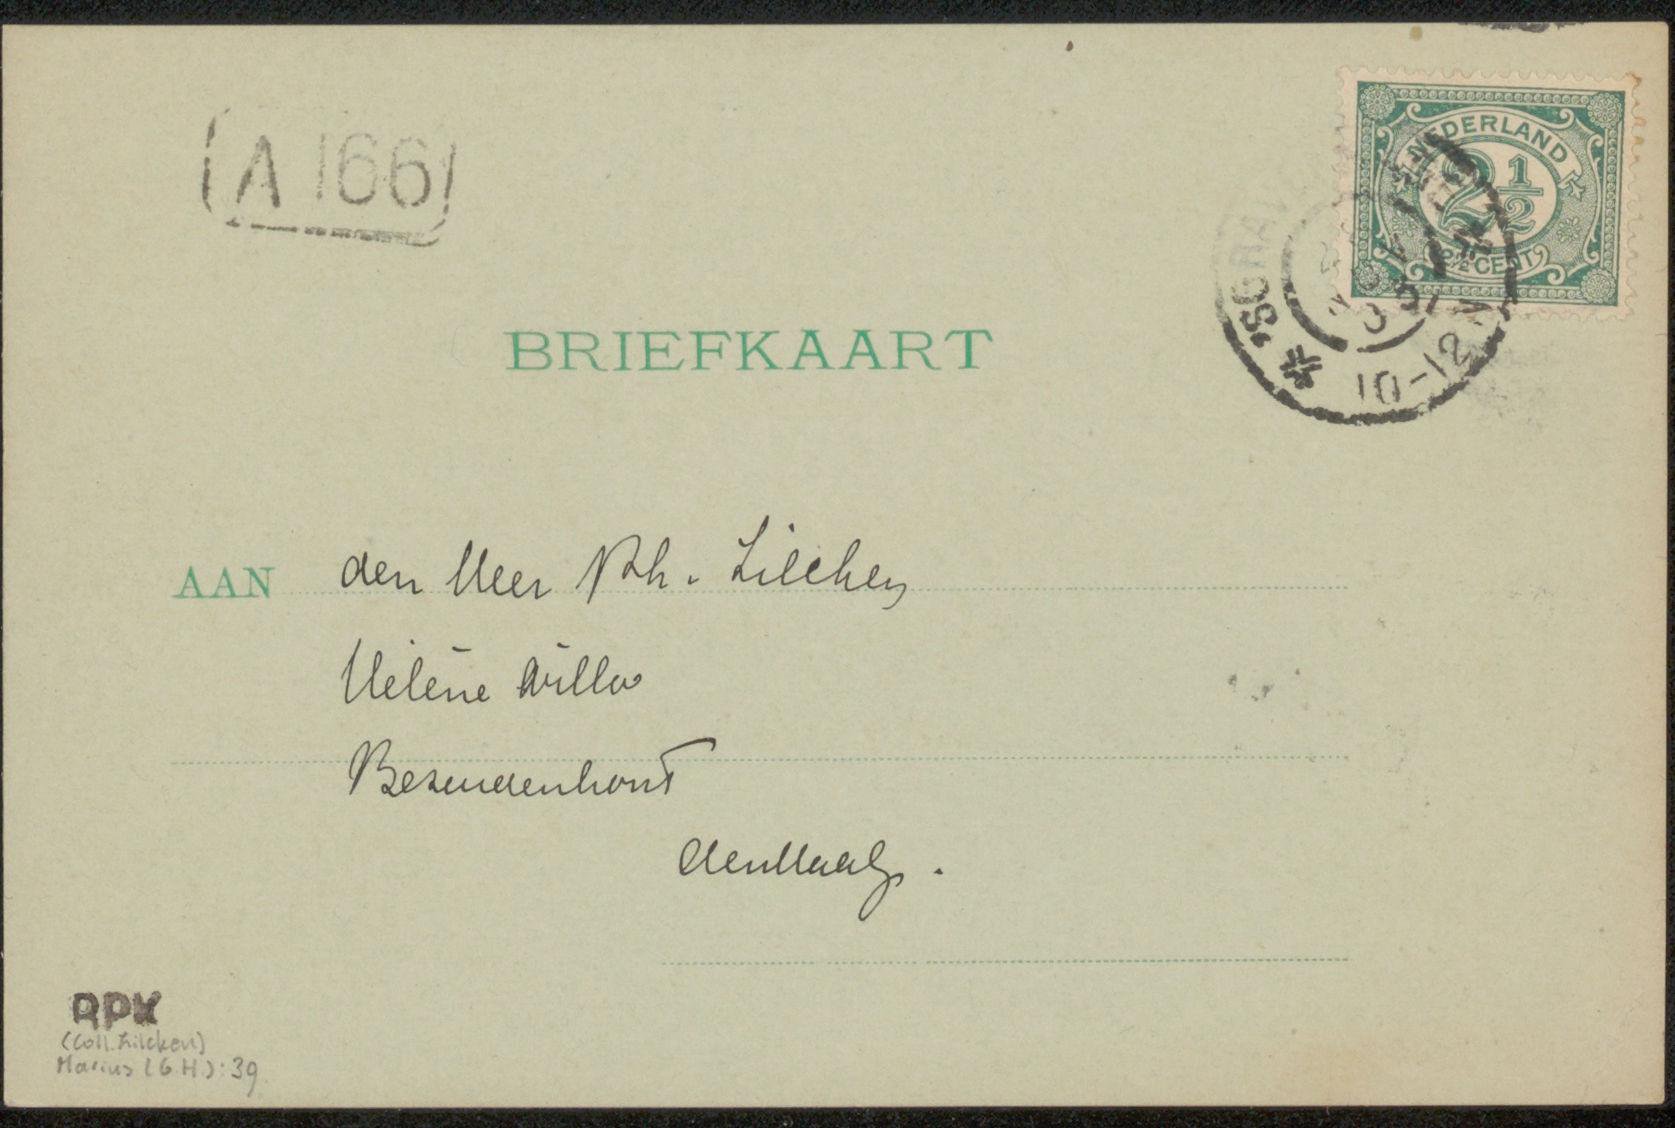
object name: postcard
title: Briefkaart aan Philip Zilcken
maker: grada hermina marius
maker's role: painter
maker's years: 1854-1919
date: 1903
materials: cardboard, ink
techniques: pen, writing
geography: the hague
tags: draughtsman, philip zilcken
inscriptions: collector's mark: ‘RPK’